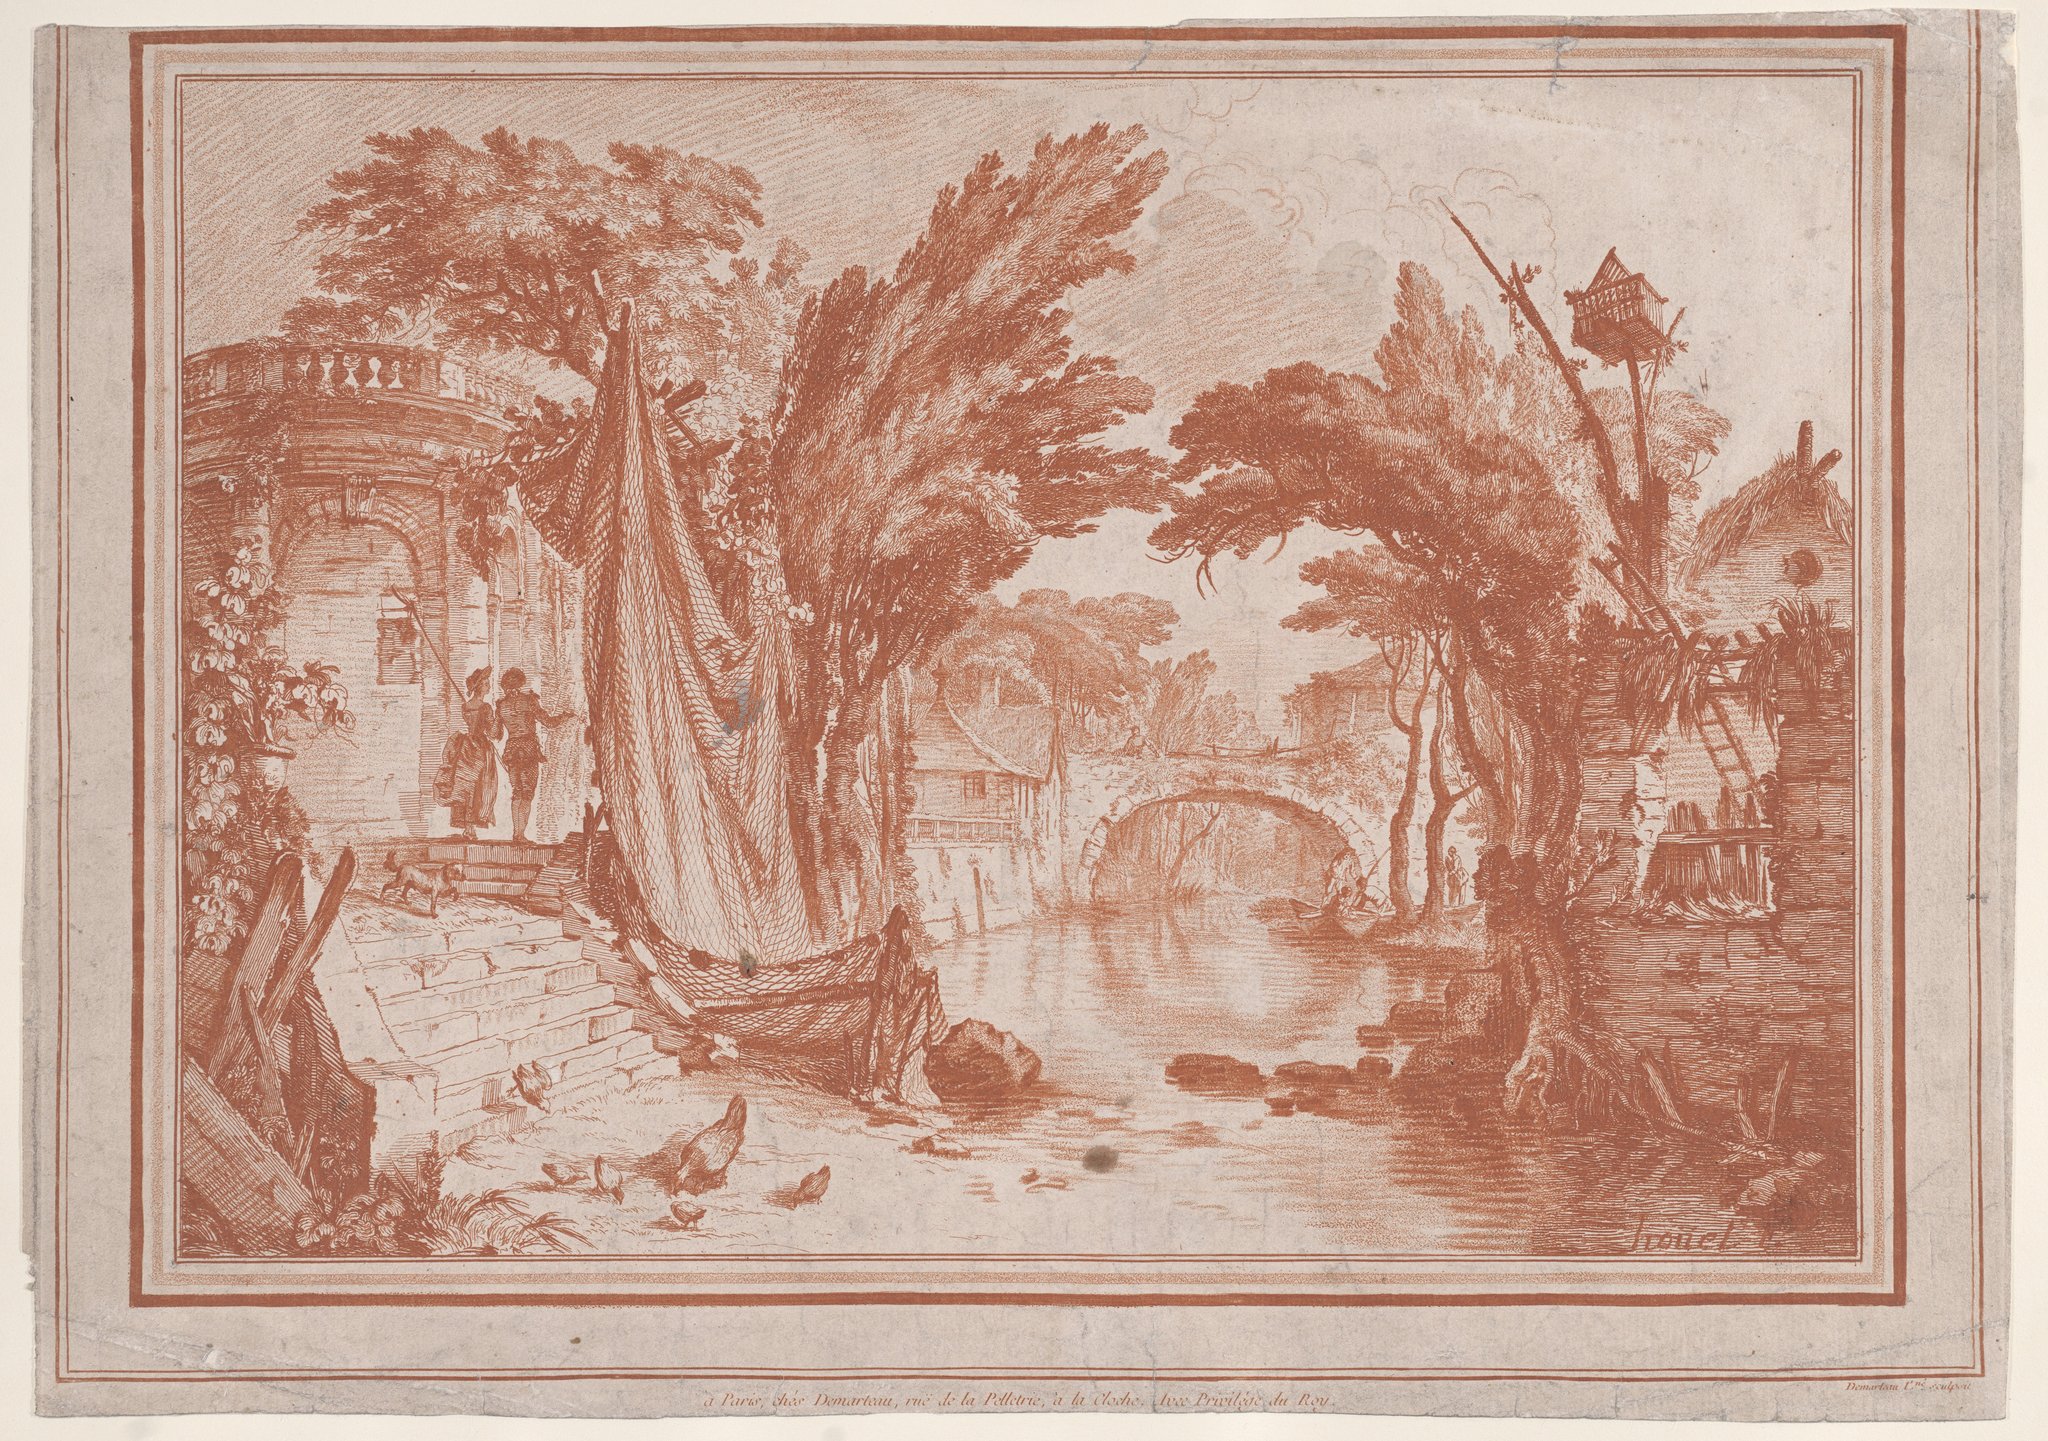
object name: print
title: Paysage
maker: gilles demarteau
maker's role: artist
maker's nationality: french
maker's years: 1722-1776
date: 1701-1800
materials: ink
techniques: printing, engraving